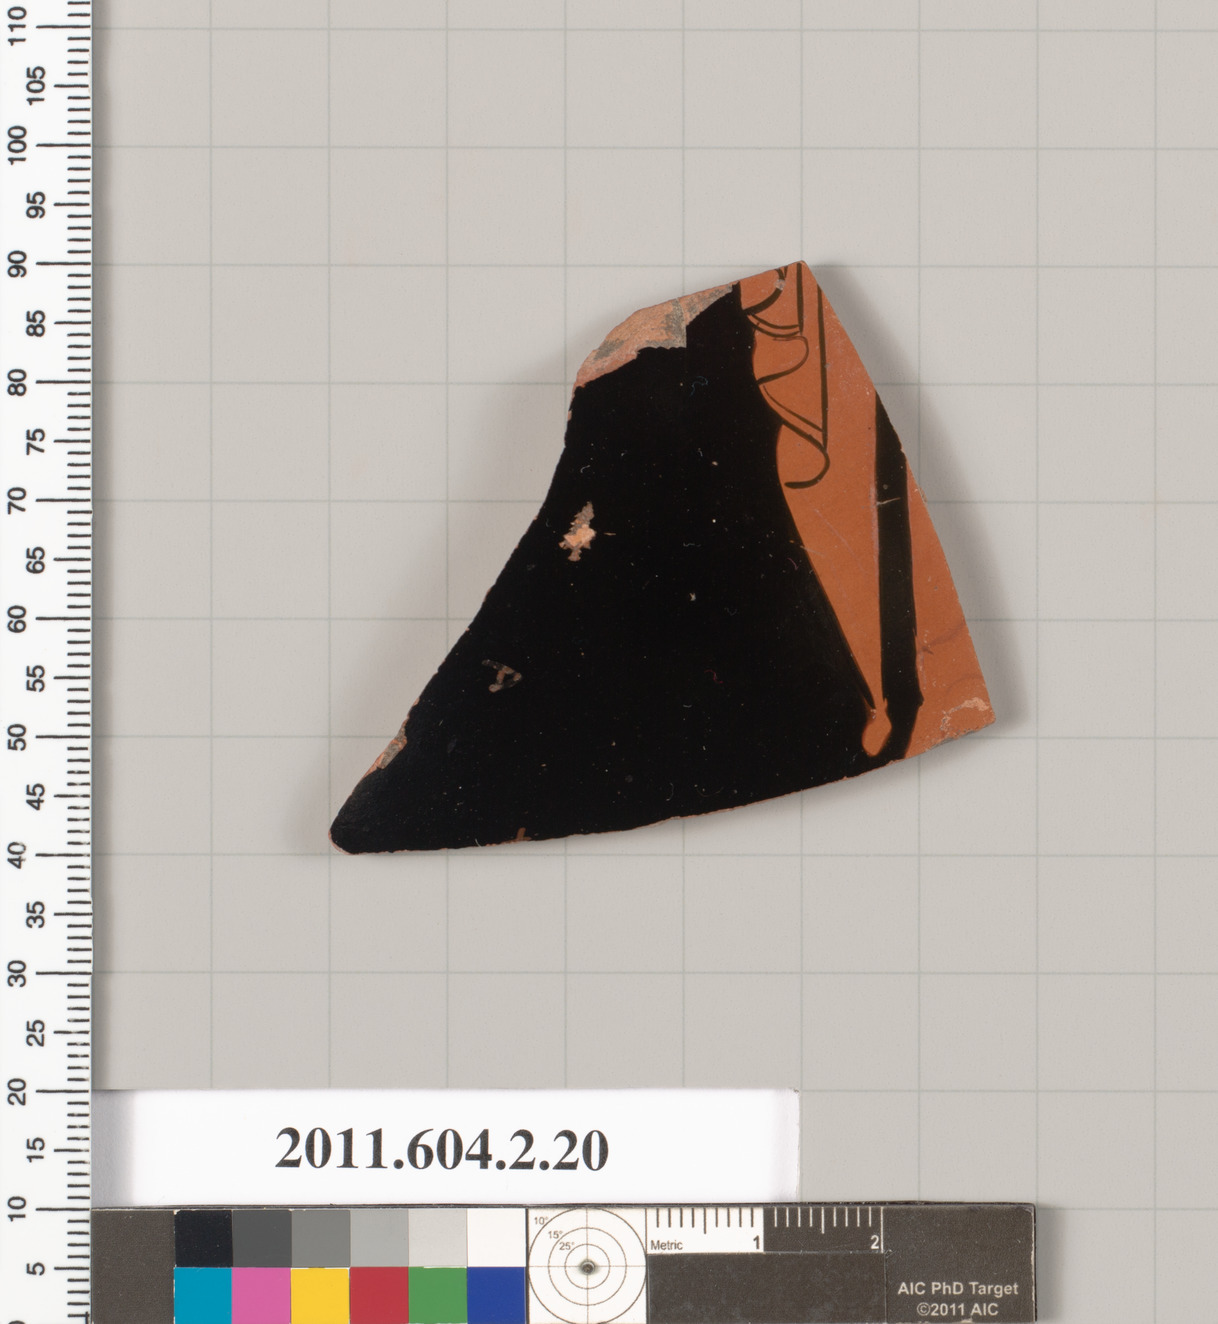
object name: psykter fragment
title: Terracotta fragment of a psykter (vase for cooling wine)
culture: greek, attic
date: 500-480 BCE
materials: terracotta